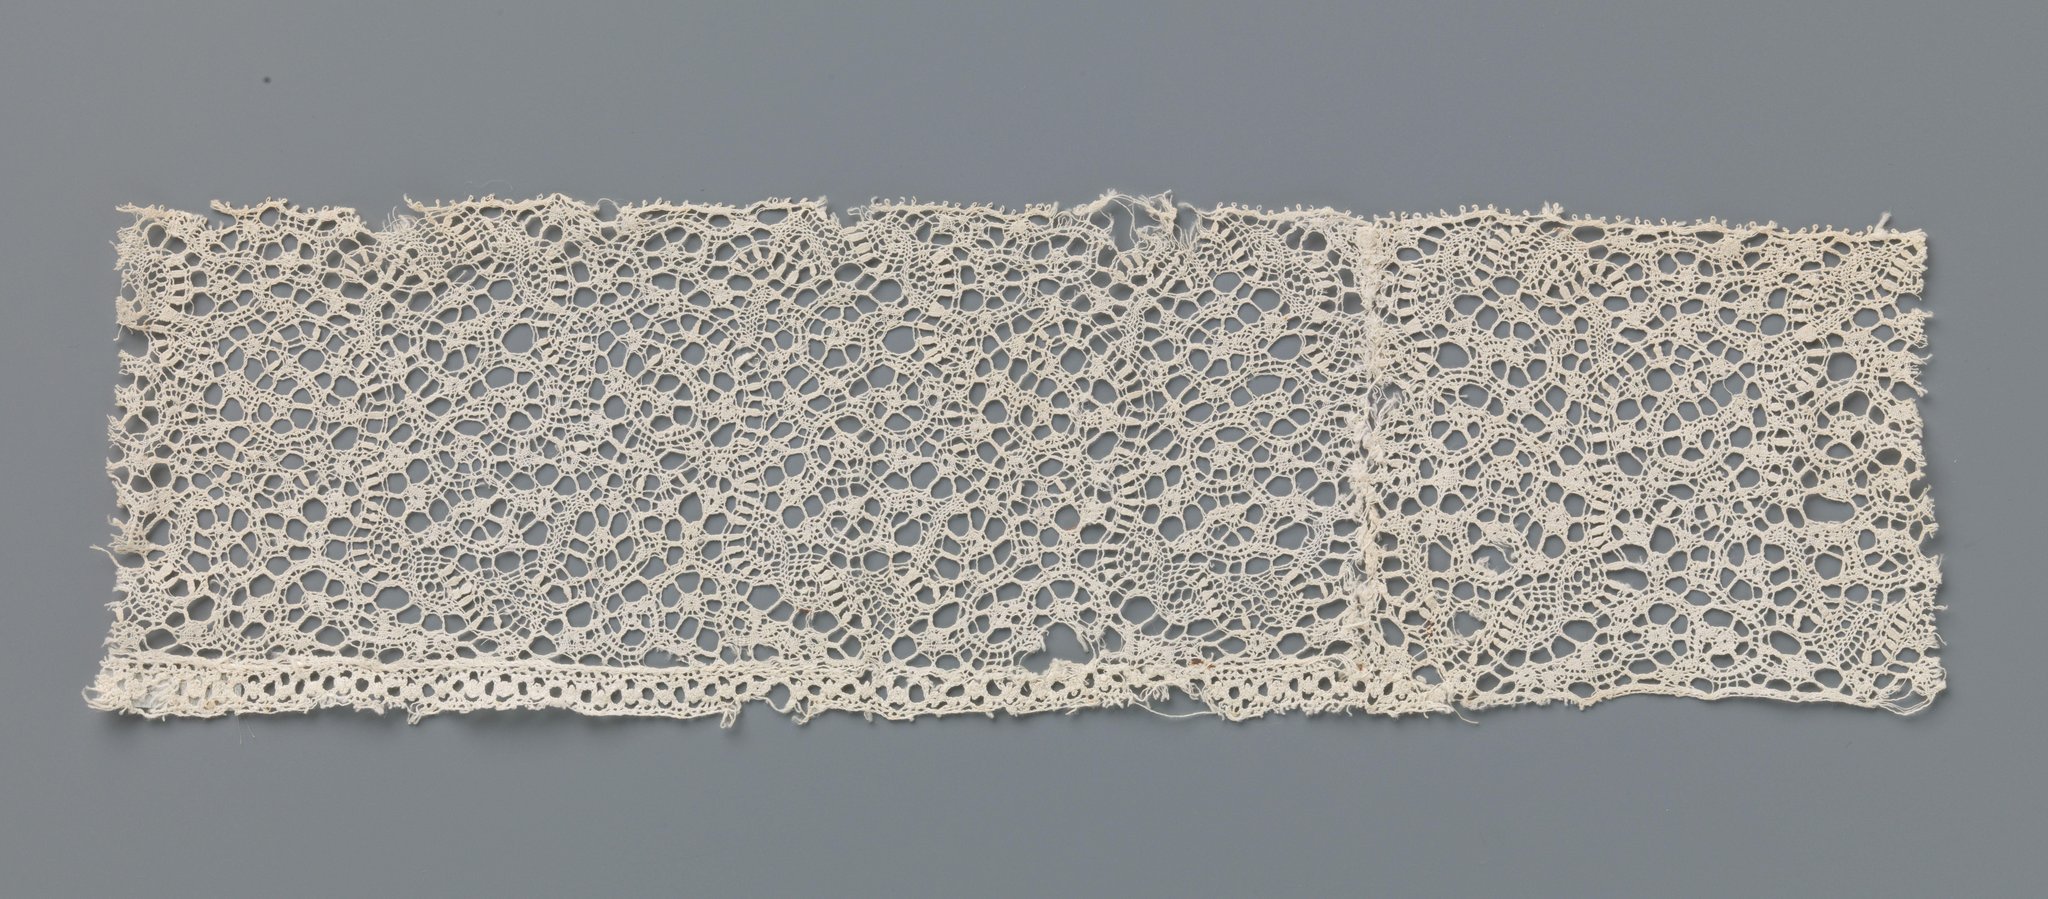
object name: strip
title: Strook kloskant met sierbanden en s-vormige rankjes met ovale knopjes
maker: Anonymous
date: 1700-1715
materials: linen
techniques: lace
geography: flanders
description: Strook naturelkleurige kloskant, oudvlaamse kant. Het ogenschijnlijk warrige, zich herhalende patroon bestaat uit een aaneenschakeling van zeer smalle s-vormige ranken met kleine ovale knopjes eraan. Sierbanden, deels spiralen vormend, lopen in bochten om de ranken heen. De motieven zijn met elkaar verbonden door een vlechtengrond. Het zeer spaarzaam toegepaste volwerk is gemaakt in netslag en linnenslag, waarbij de opengewerkte randjes ongeveer even breed zijn als het volwerk waarmee de ranken zijn gemaakt. Er is één soort siergrond toegepast in de spiralen en in de sierbanden staan rijen blaadjes gemaakt in vormslag. De bovenzijde van de strook is recht afgewerkt met een apart geklost bandje. De onderzijde is recht afgewerkt met picots.